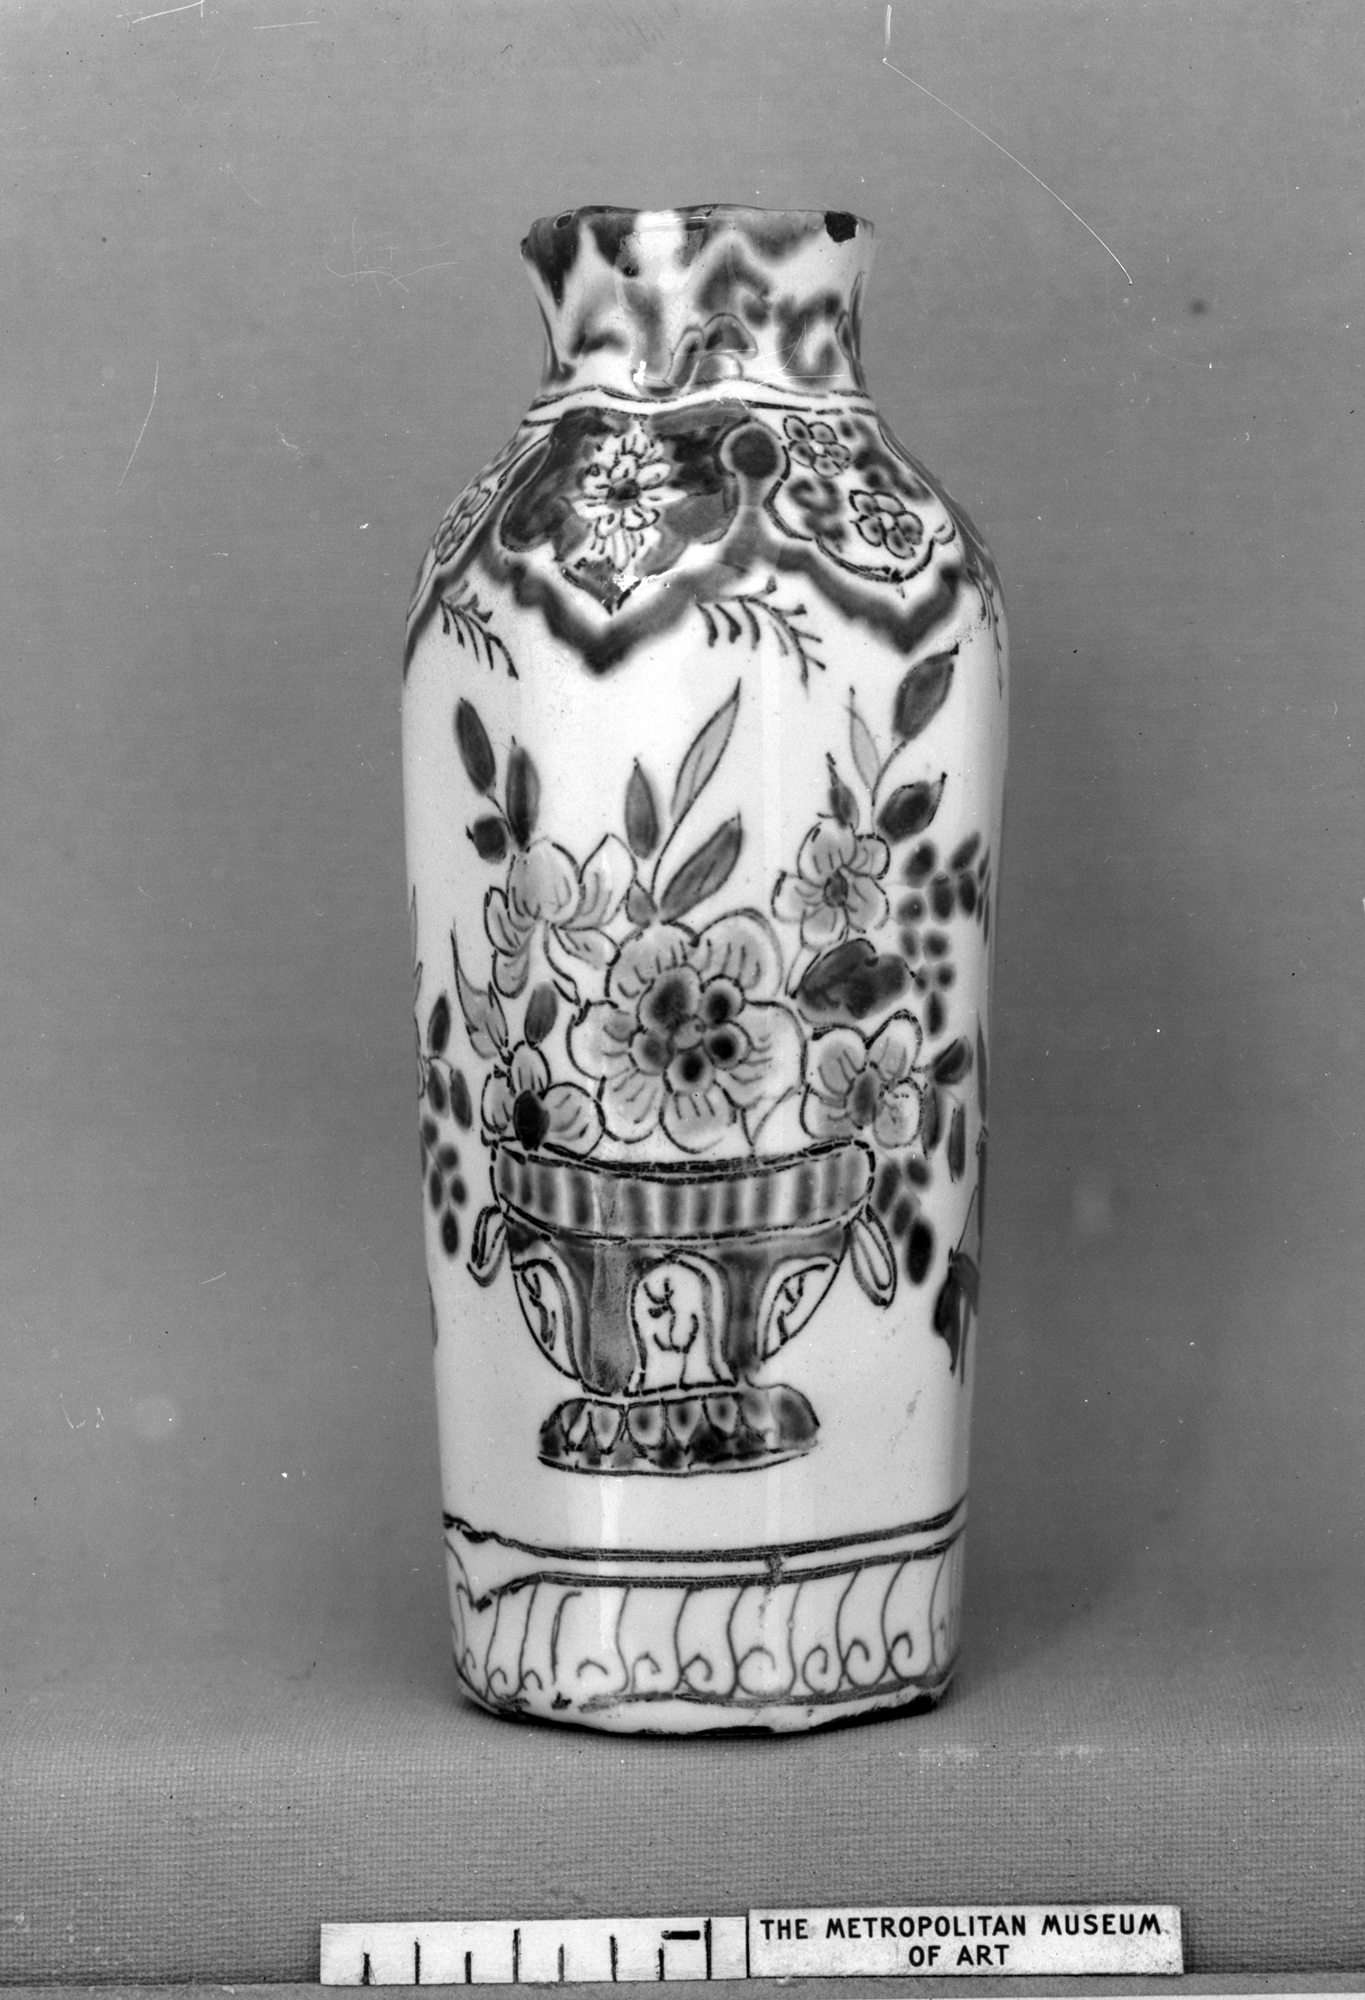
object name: vase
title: Vase (one of a pair)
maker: anthoni pennis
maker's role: maker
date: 1751-1800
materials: earthenware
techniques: glazing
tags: flowers